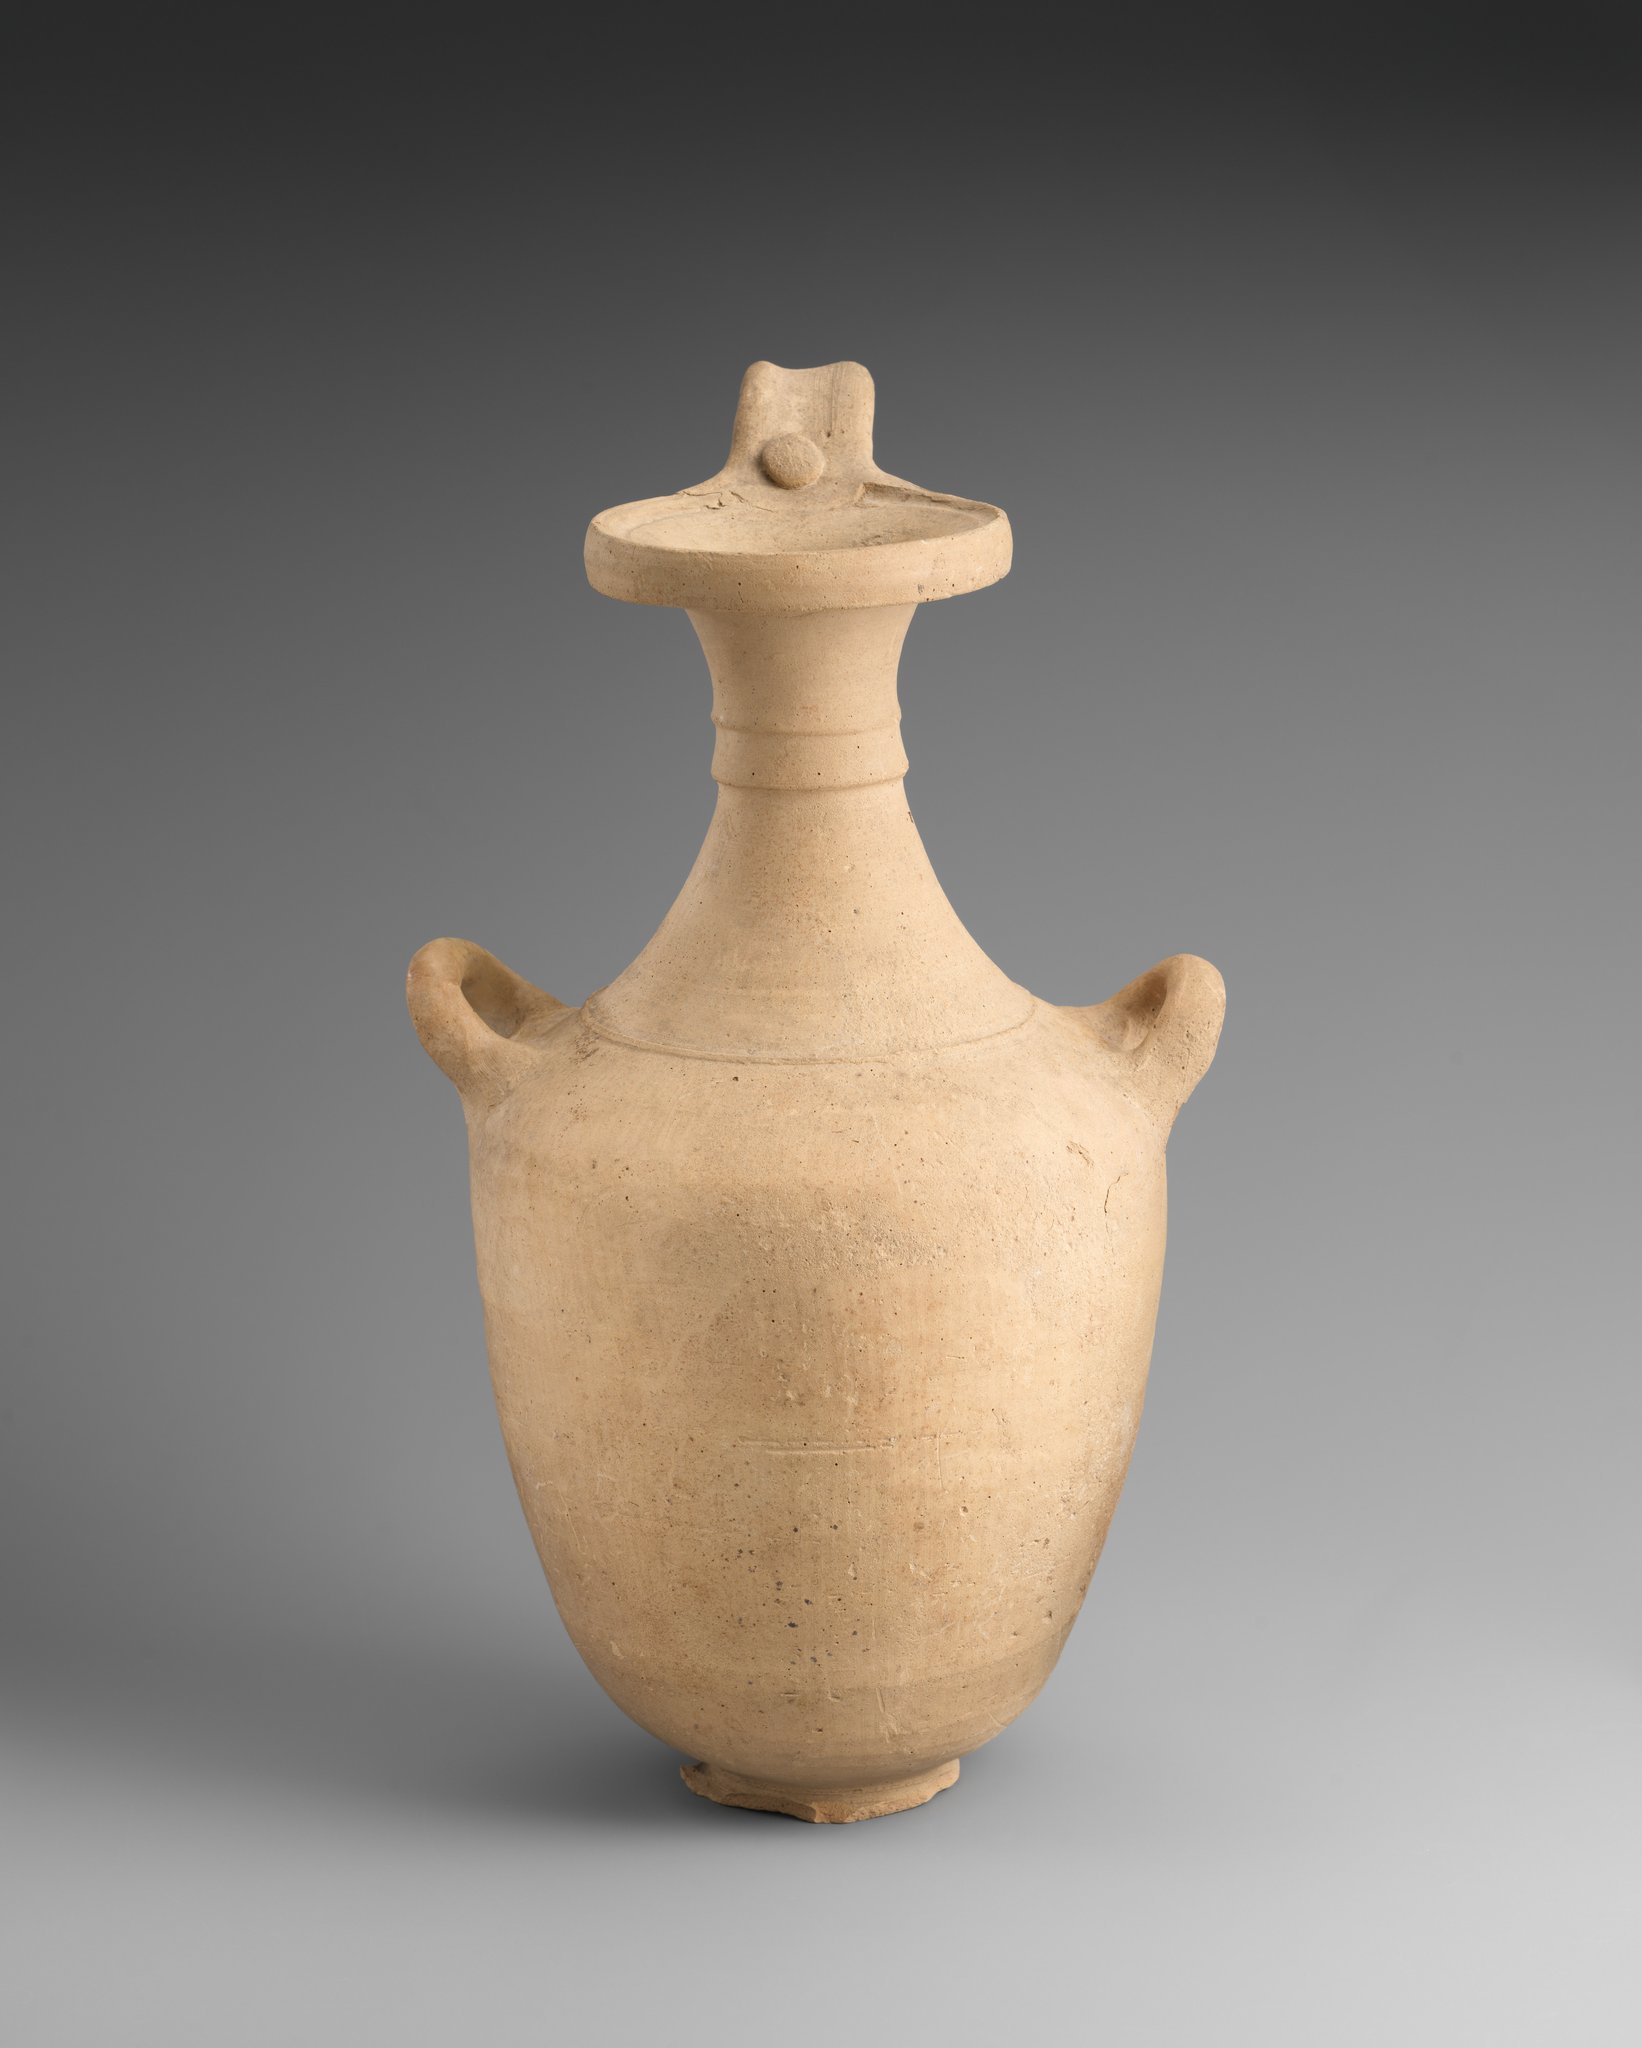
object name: jug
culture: cypriot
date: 400-310 BCE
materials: terracotta